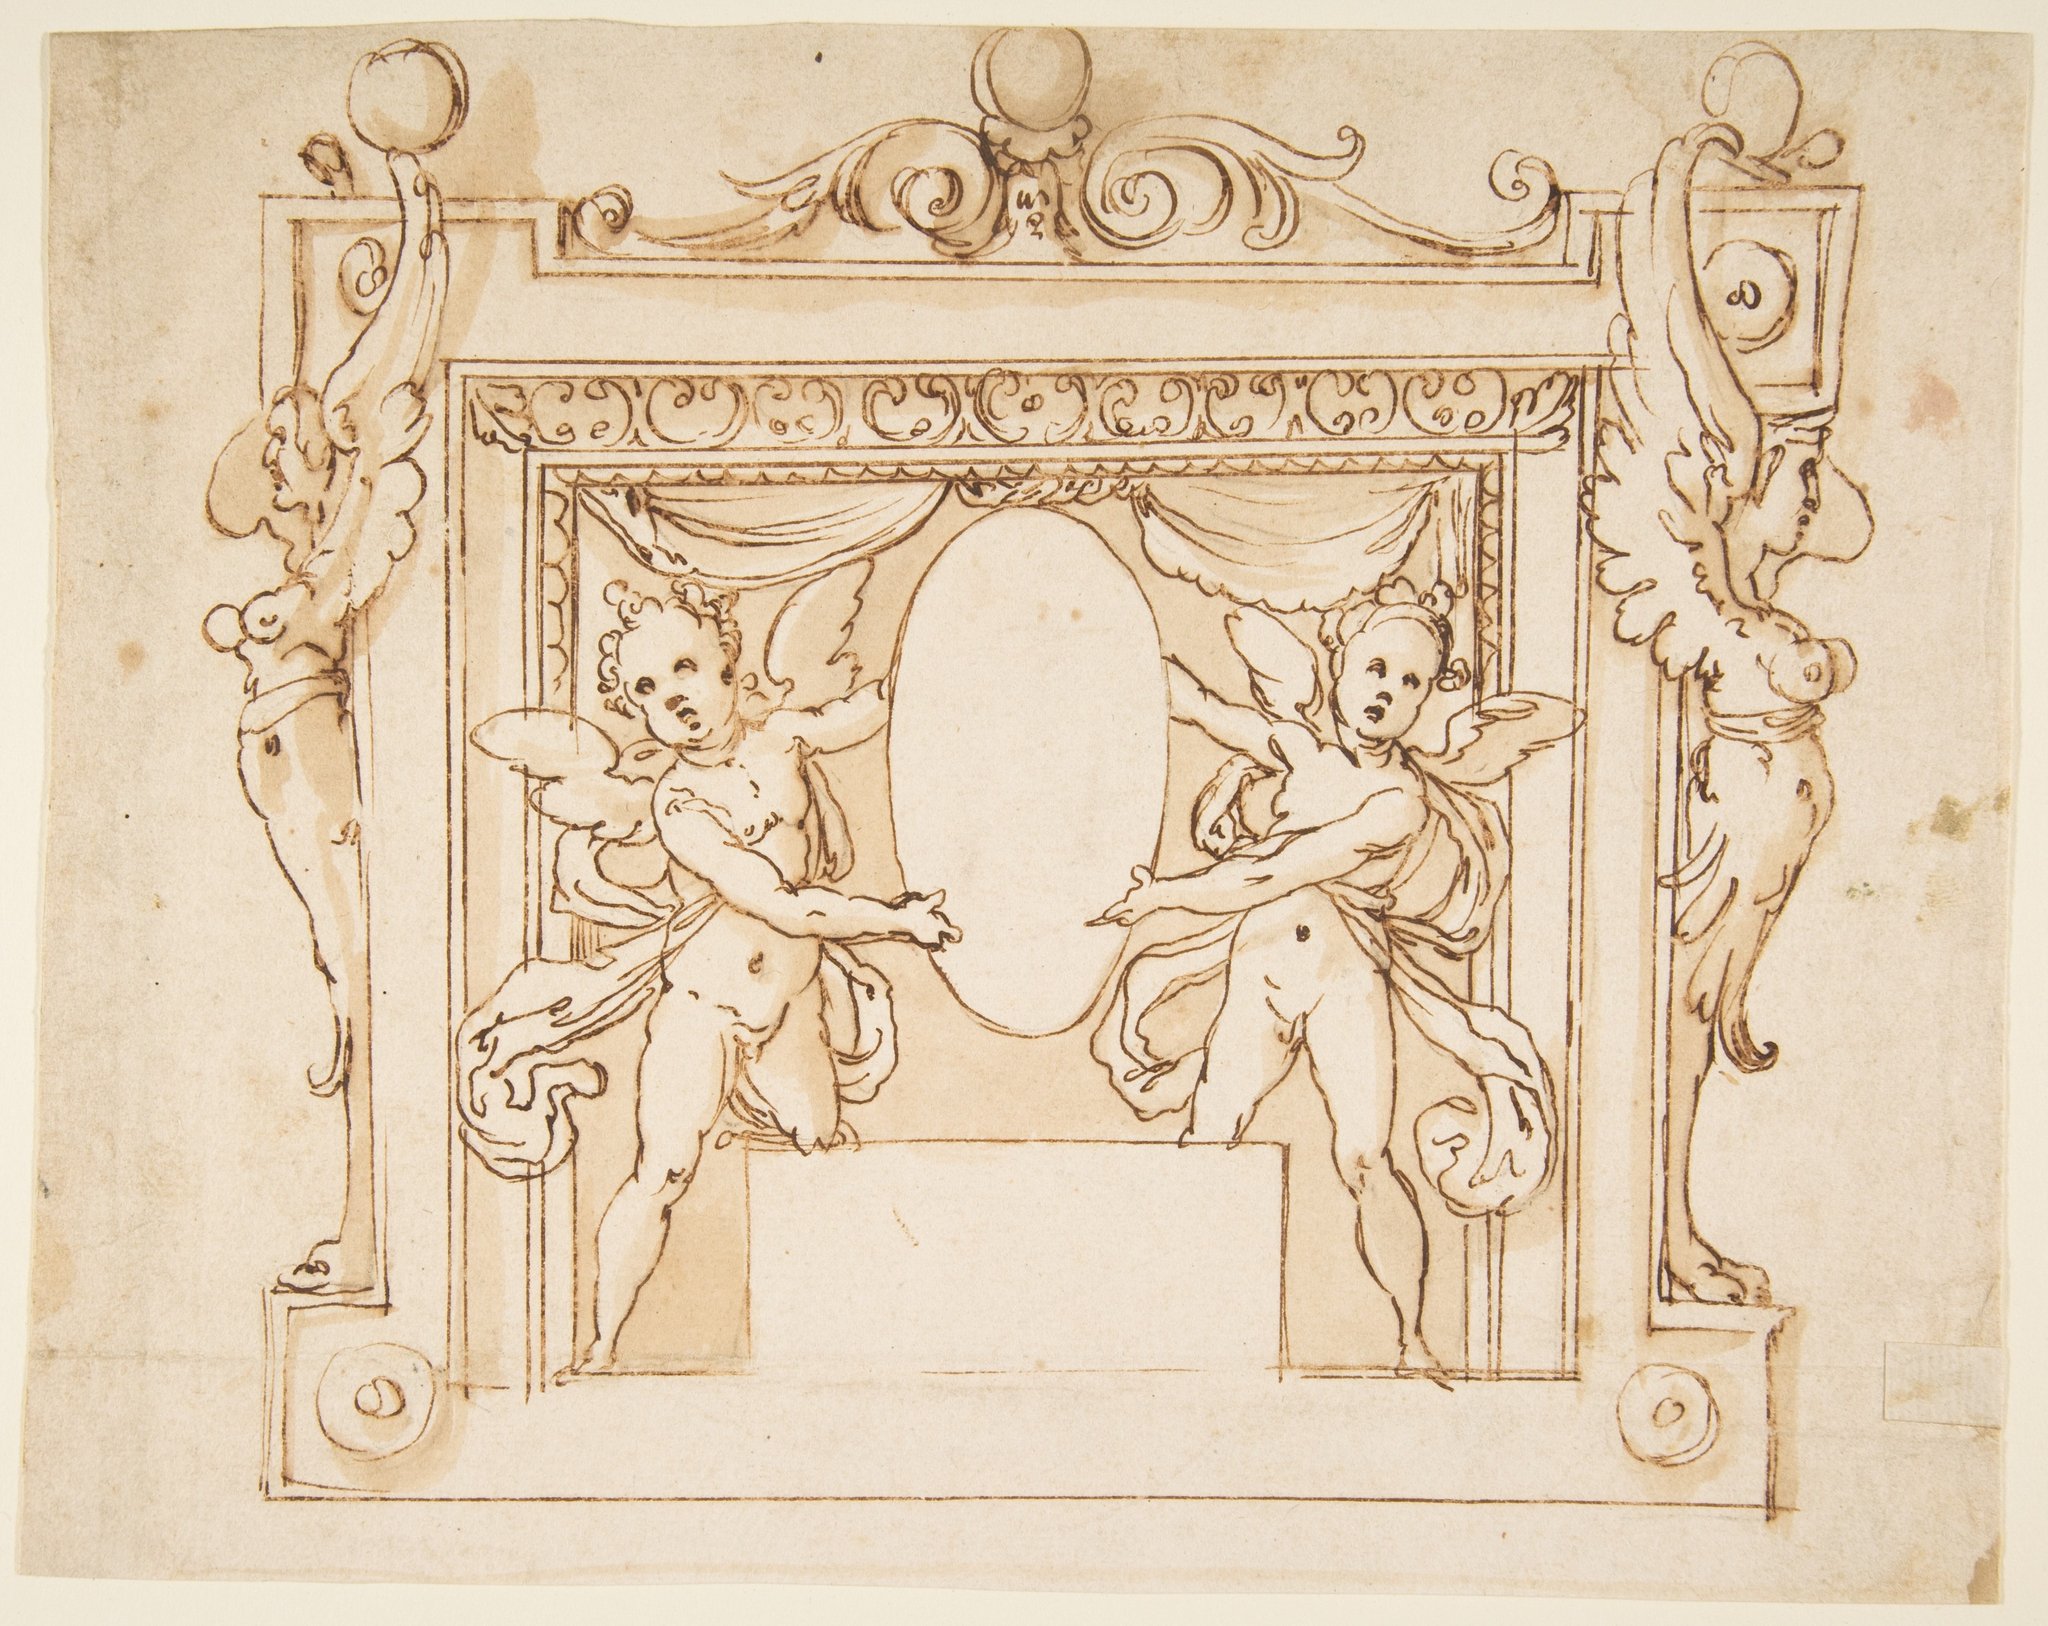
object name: drawing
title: Drawing for a Memorial Tablet: Two Winged Children Holding an Empty Oval in a Frame with Gryphons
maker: federico zuccaro (zuccari)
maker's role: artist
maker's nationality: italian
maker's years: 1540-1609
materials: ink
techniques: pen, wash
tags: cupid,griffins